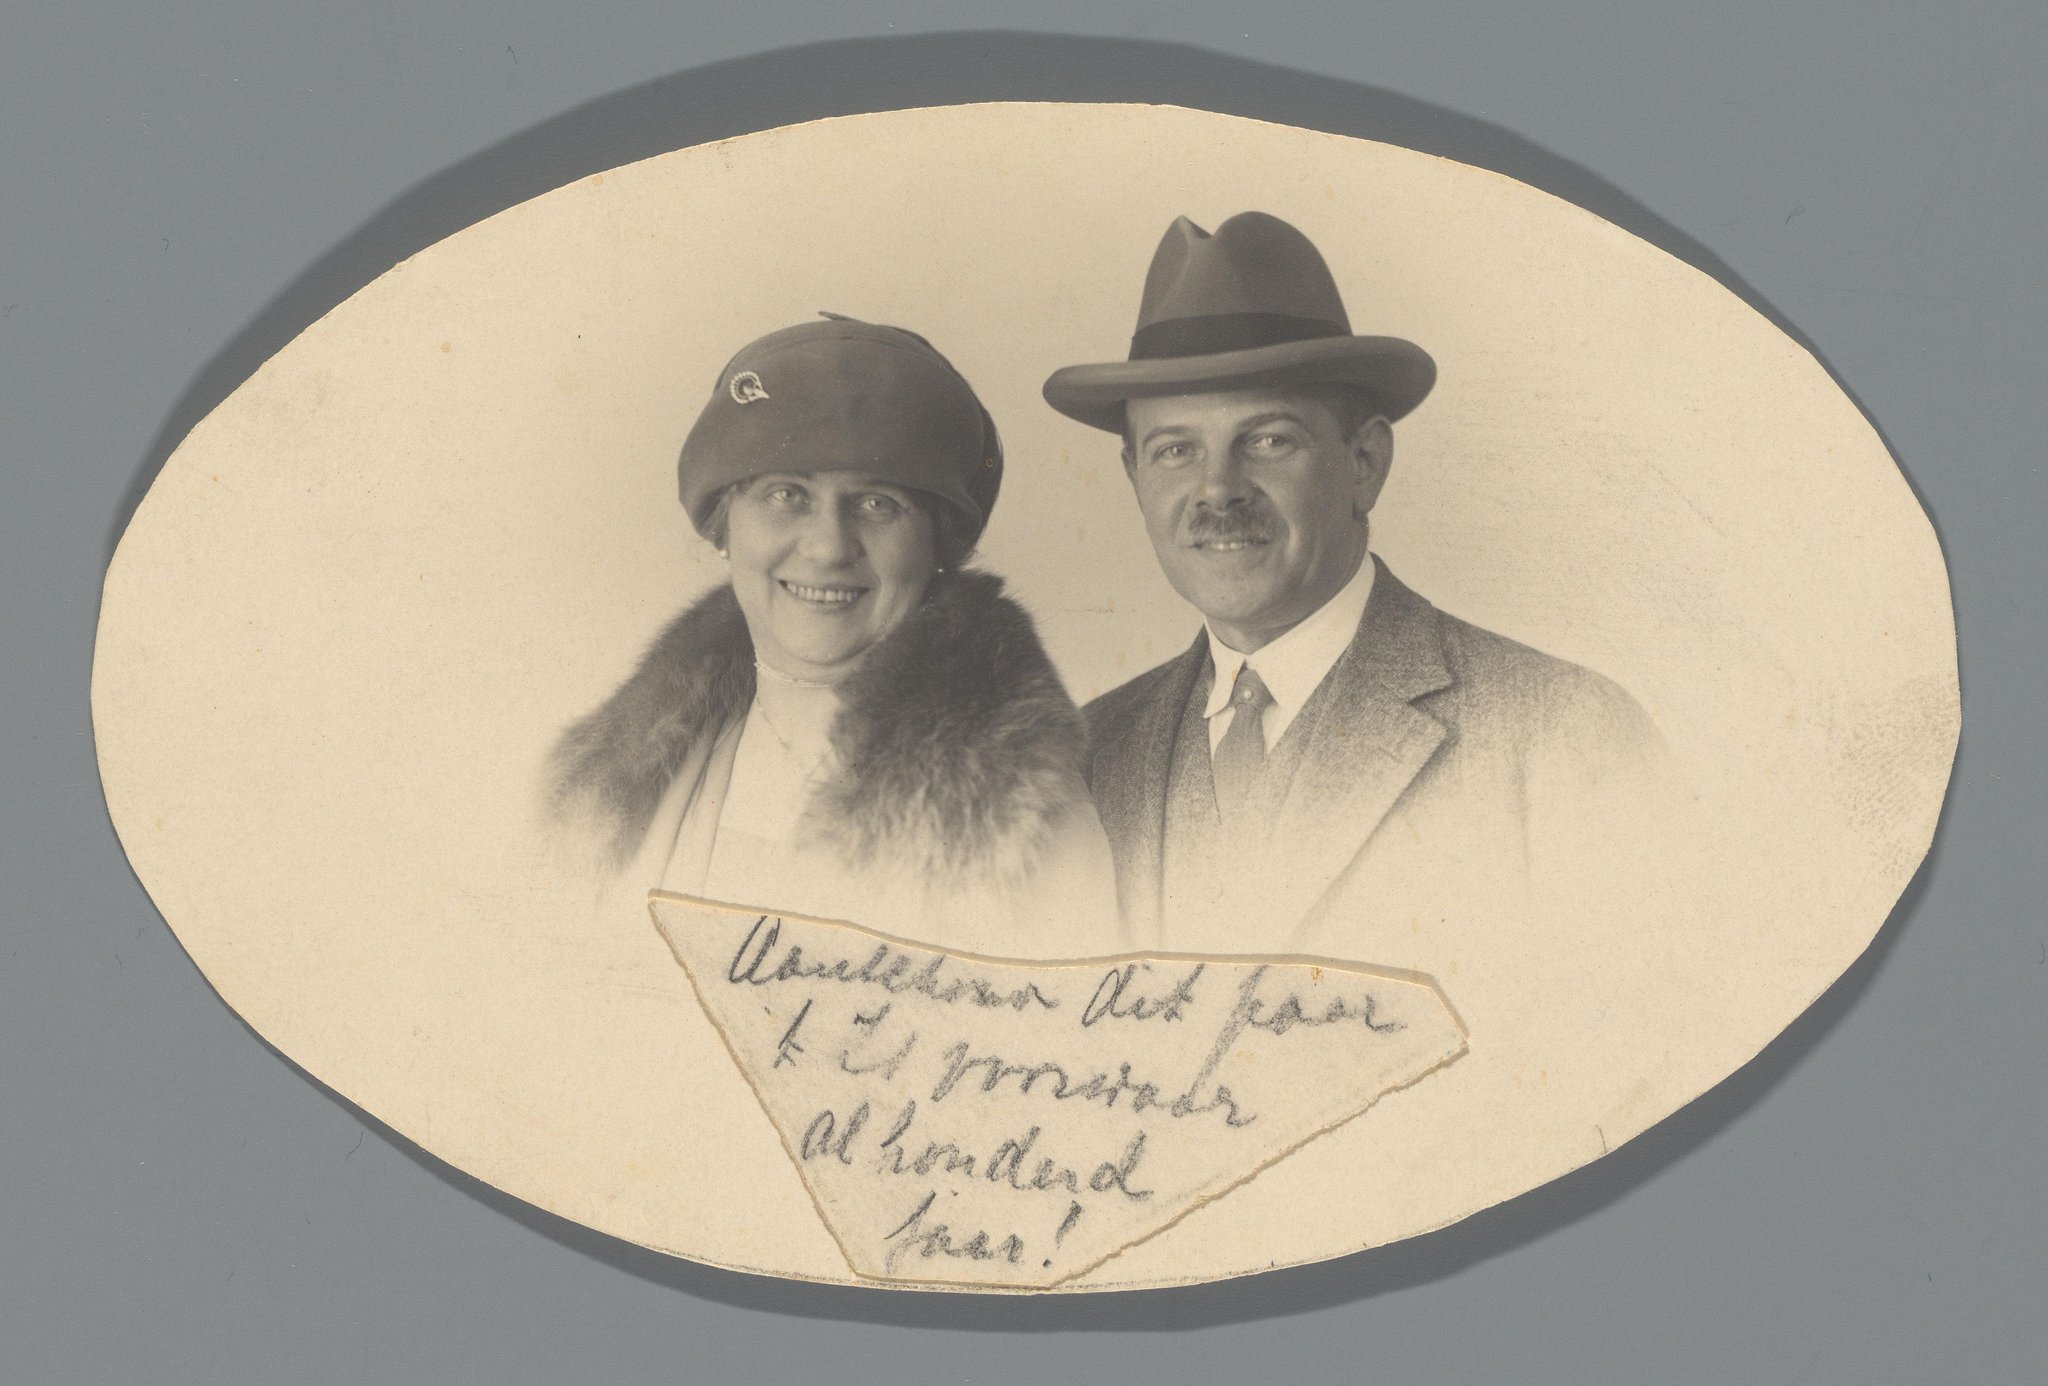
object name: photograph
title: Ovale foto met portret van Line van den Berg en Hendrik Herman van den Berg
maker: Anonymous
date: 1925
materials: photographic support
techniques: photography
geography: netherlands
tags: batavia, amsterdam, hendrik herman van den berg, the hague, caroline louise van den berg-van den berg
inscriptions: inscription: ‘1925’, inscription: ‘.... dit jaar / ... voorwaar / al honderd / jaar!’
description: Line van den Berg draagt een hoed en een bontkraag. Hendrik Herman van den Berg draagt een gleufhoed.